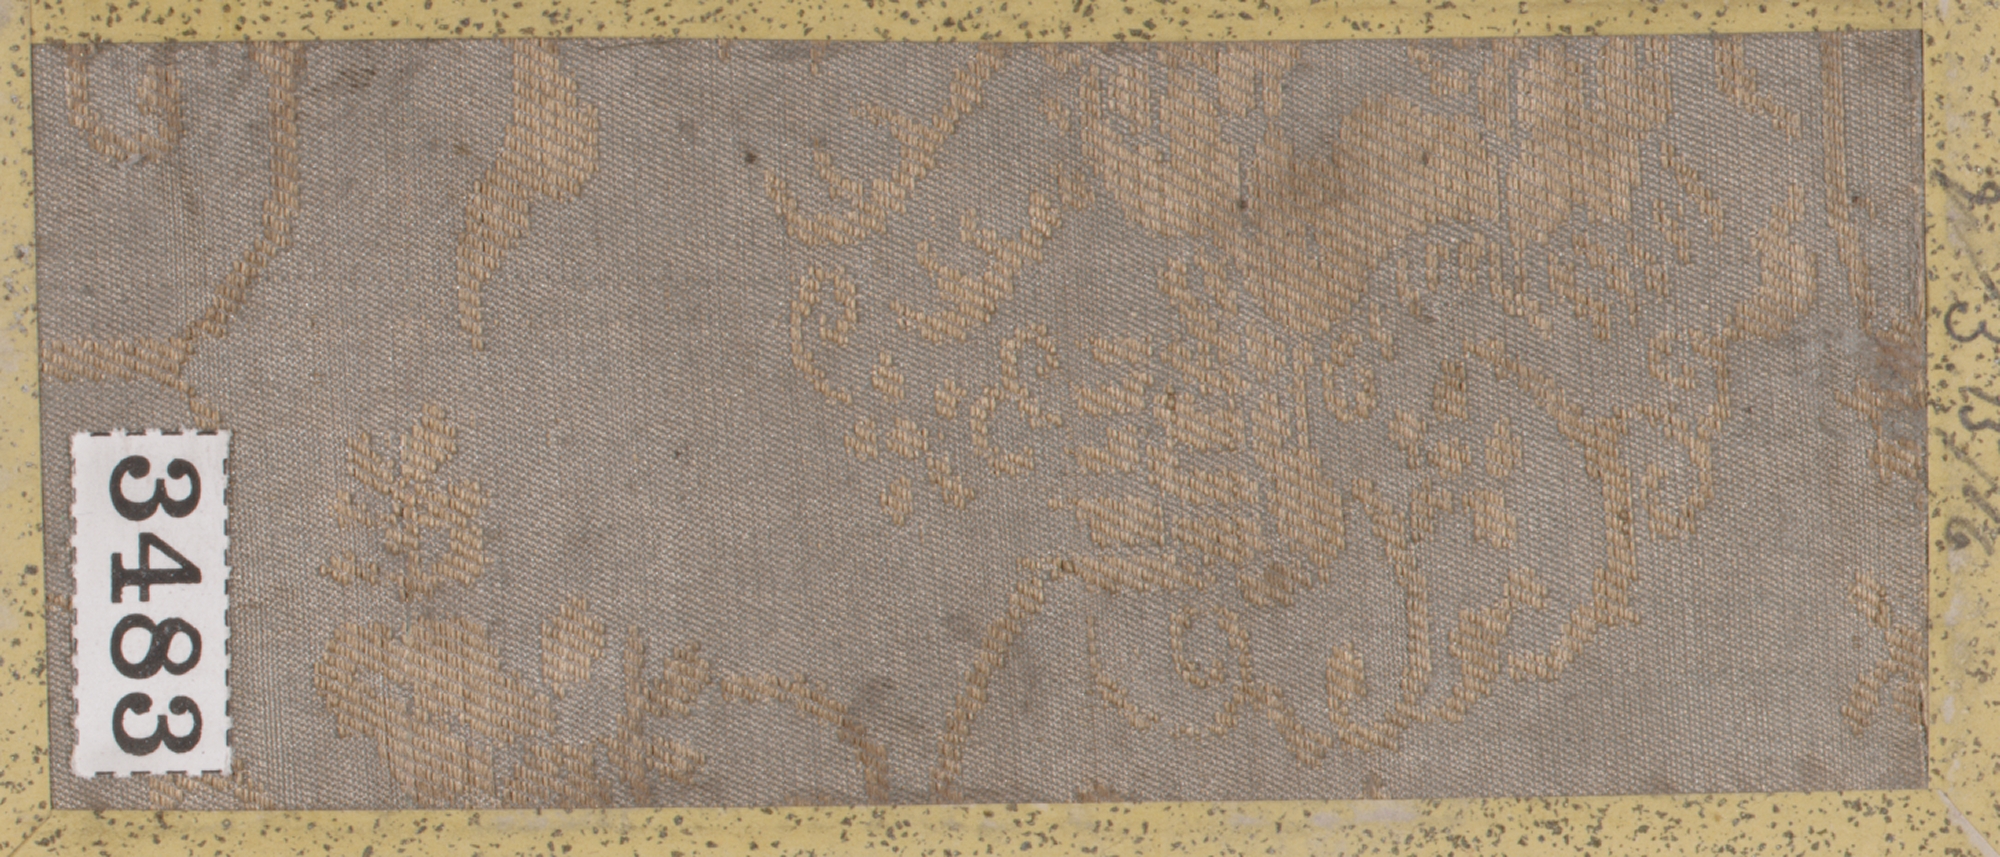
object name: sample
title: Textile Sample from Sample Book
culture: japanese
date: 1801-1900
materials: silk